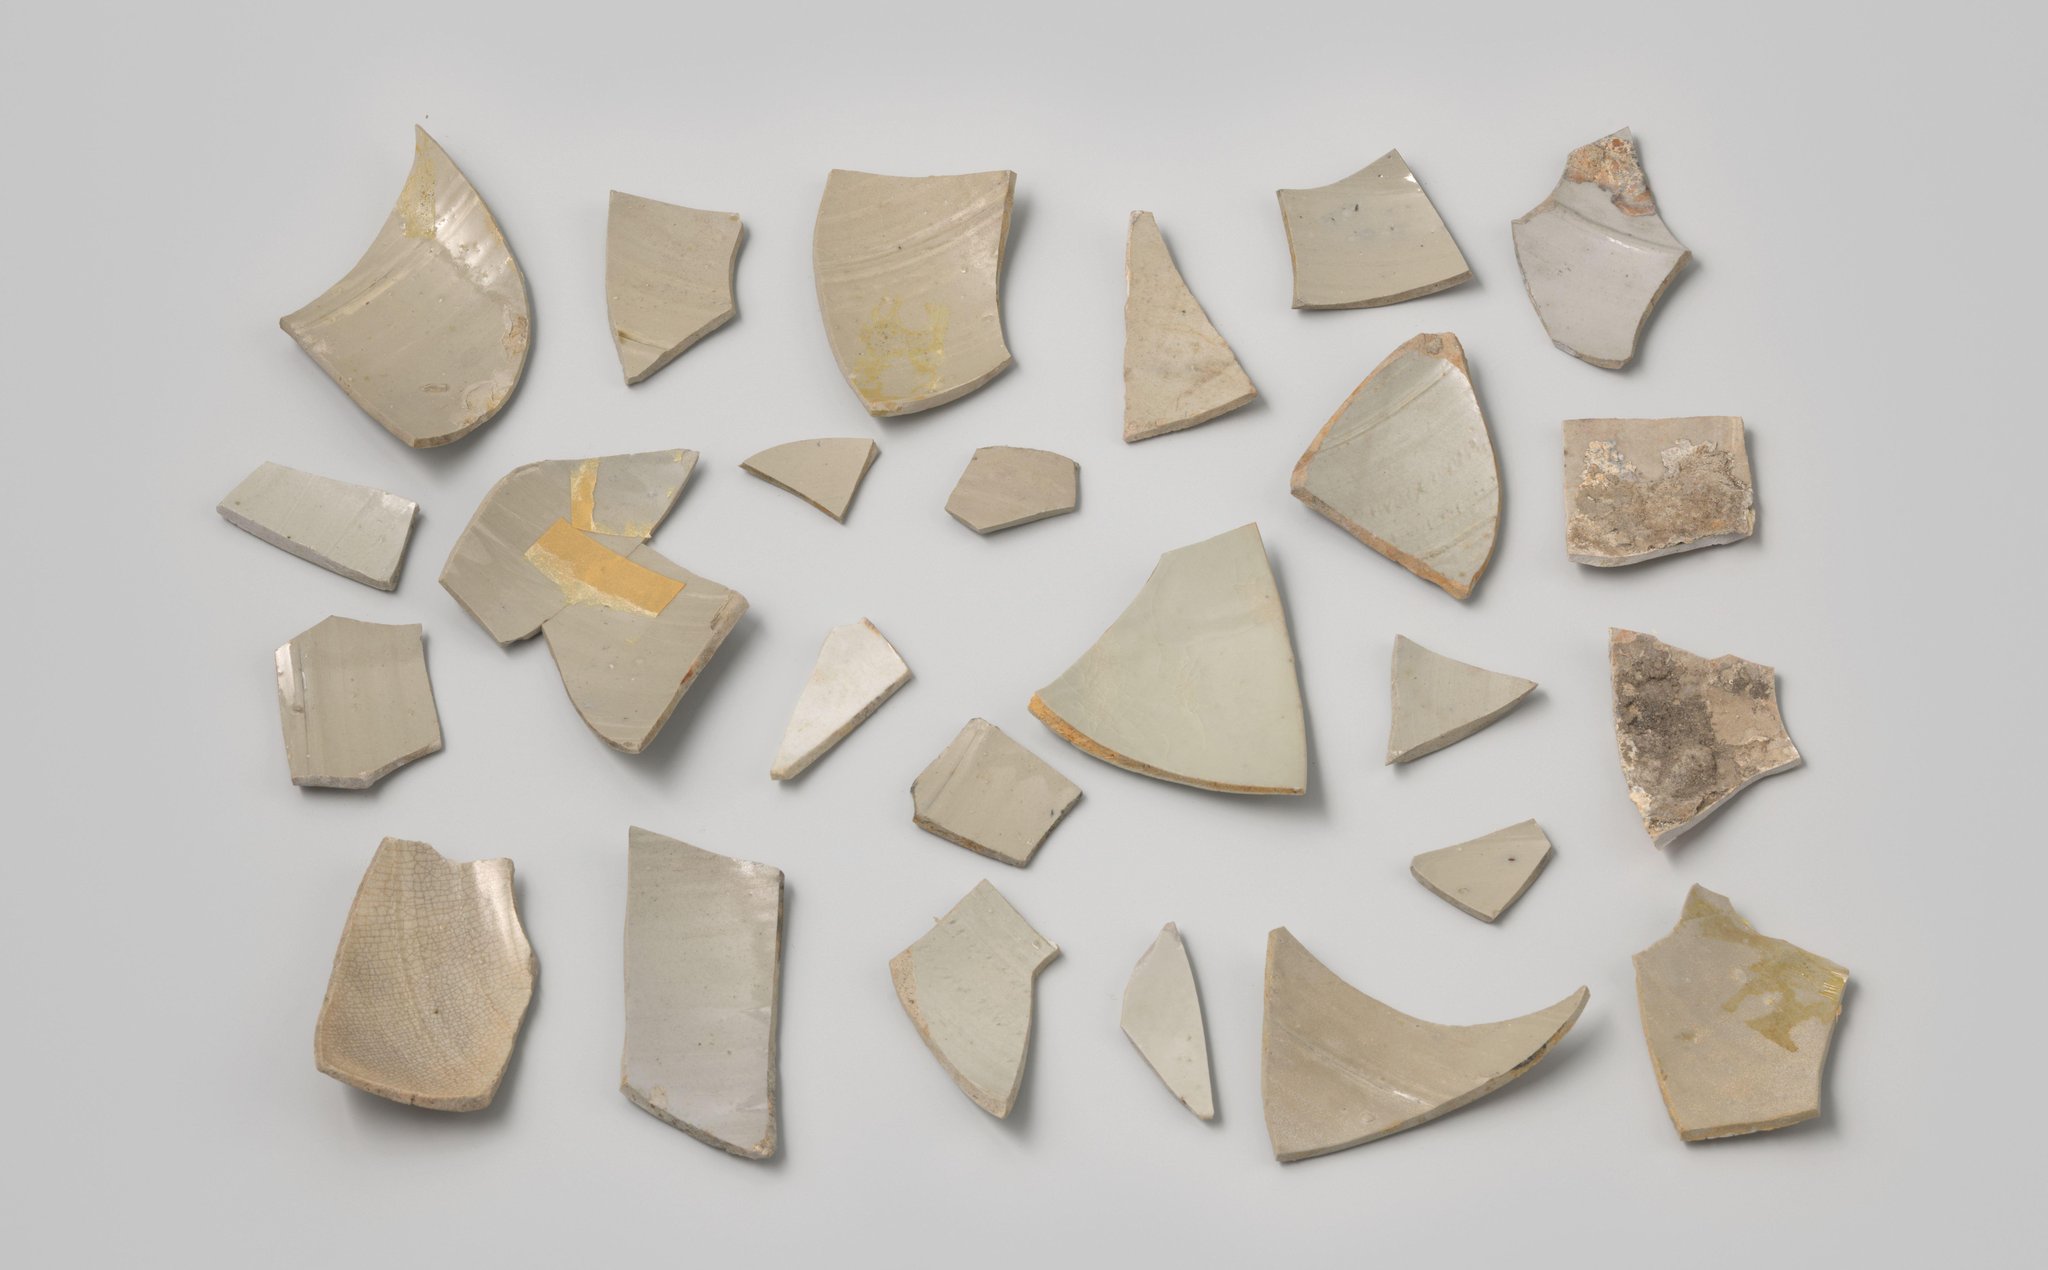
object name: martavaan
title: Scherven porselein uit V.O.C.-schip de 'Witte Leeuw'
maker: Anonymous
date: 1613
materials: porcelain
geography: jingdezhen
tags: verenigde oostindische compagnie, sint-helena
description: Scherven porselein uit V.O.C.-schip de 'Witte Leeuw', afkomstig van martavanen. Eén bestaande uit twee aan elkaar gelijmde fragmenten.